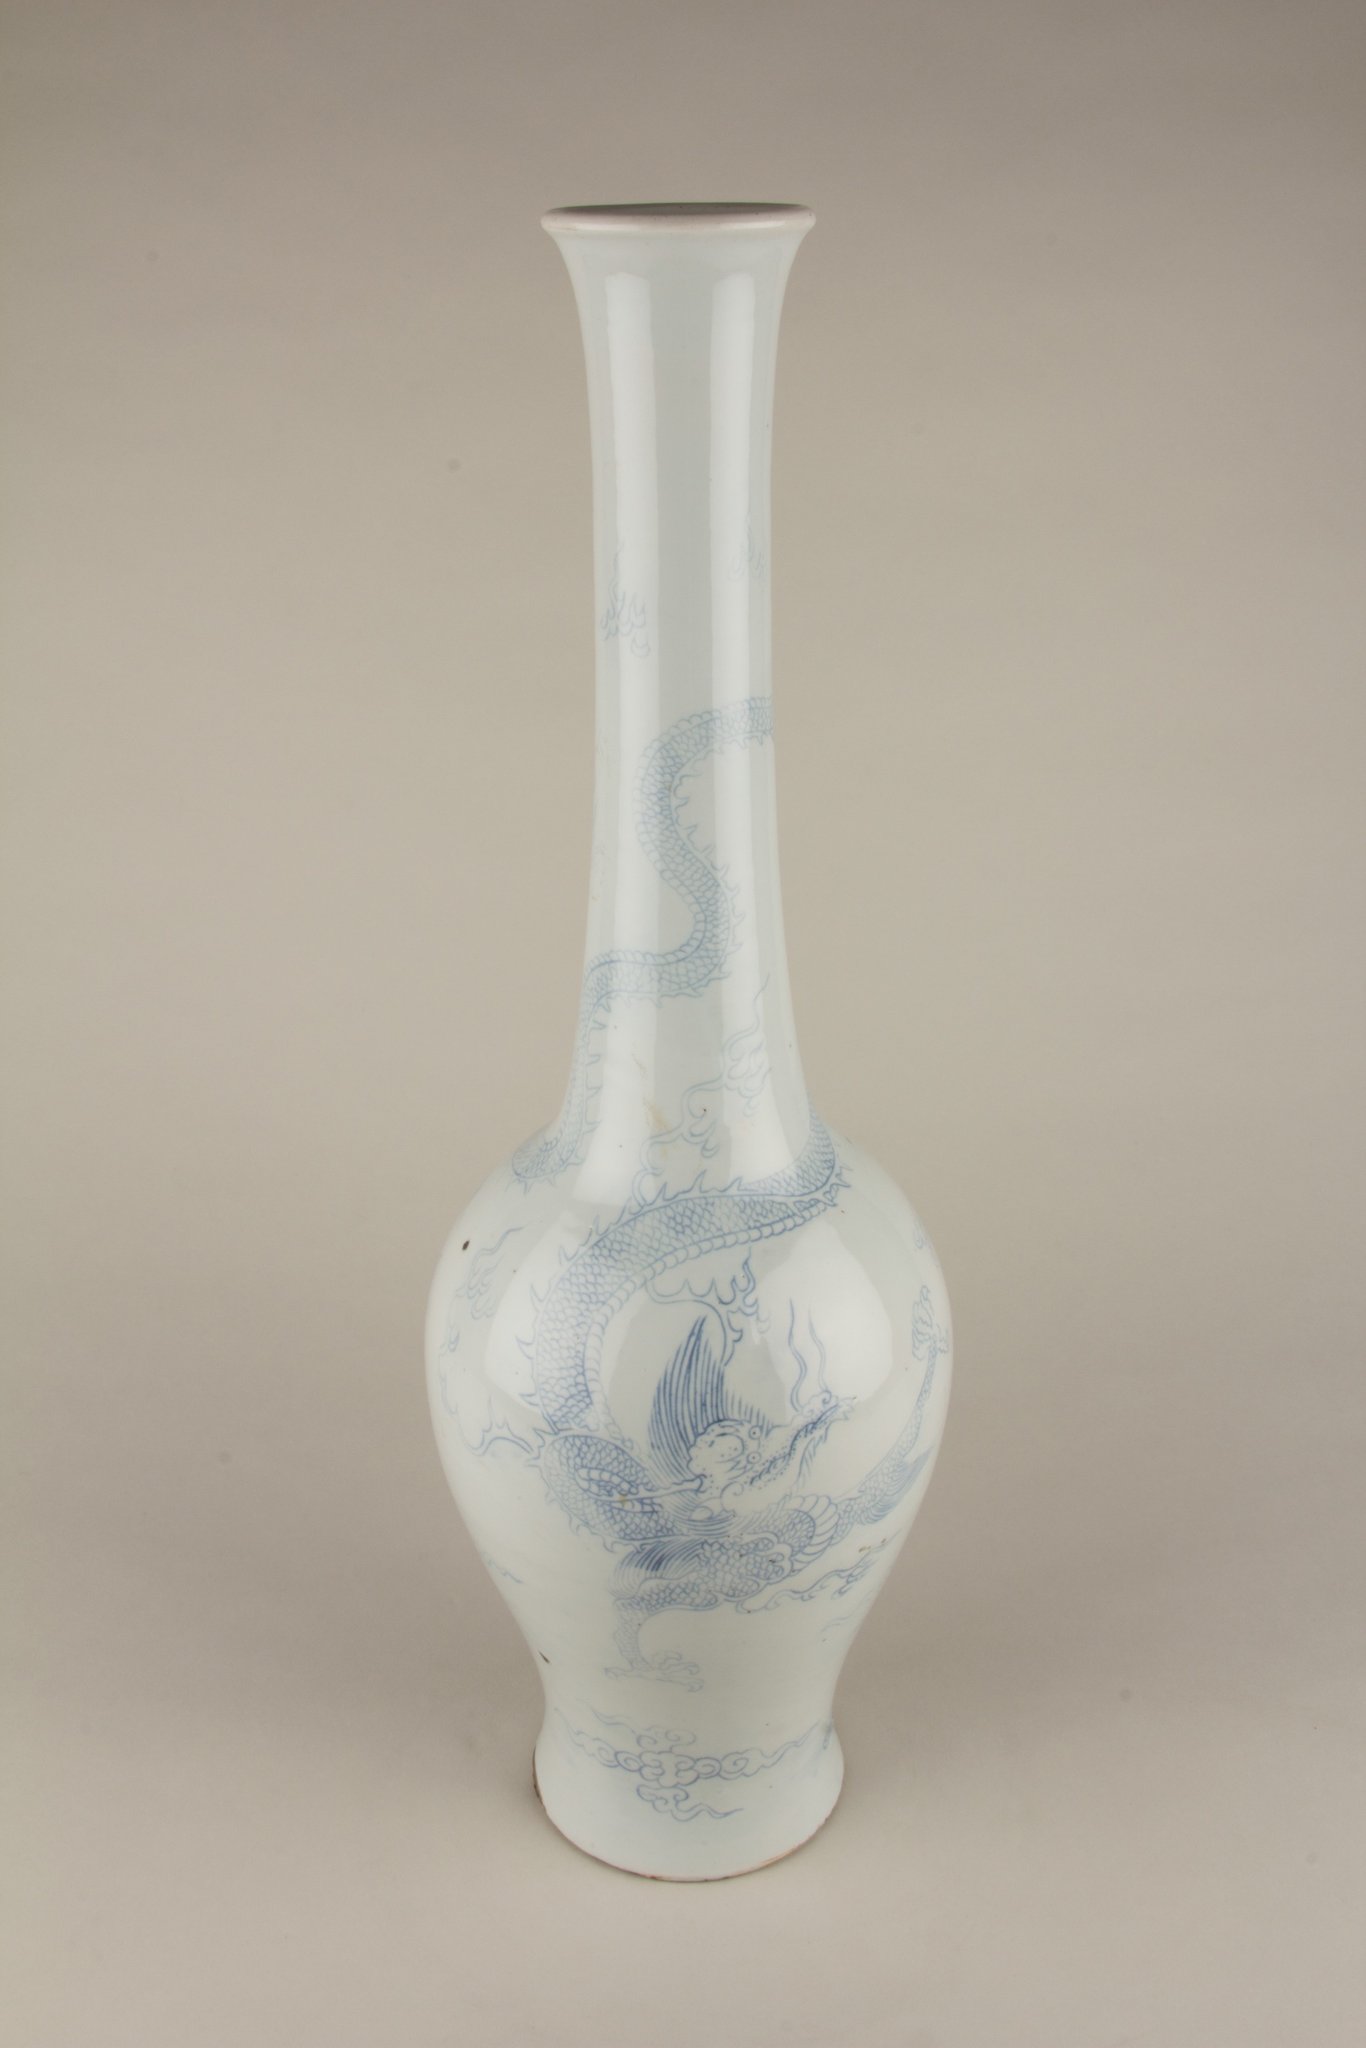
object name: vase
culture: chinese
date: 1801-1850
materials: glaze, porcelain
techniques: incising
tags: dragons